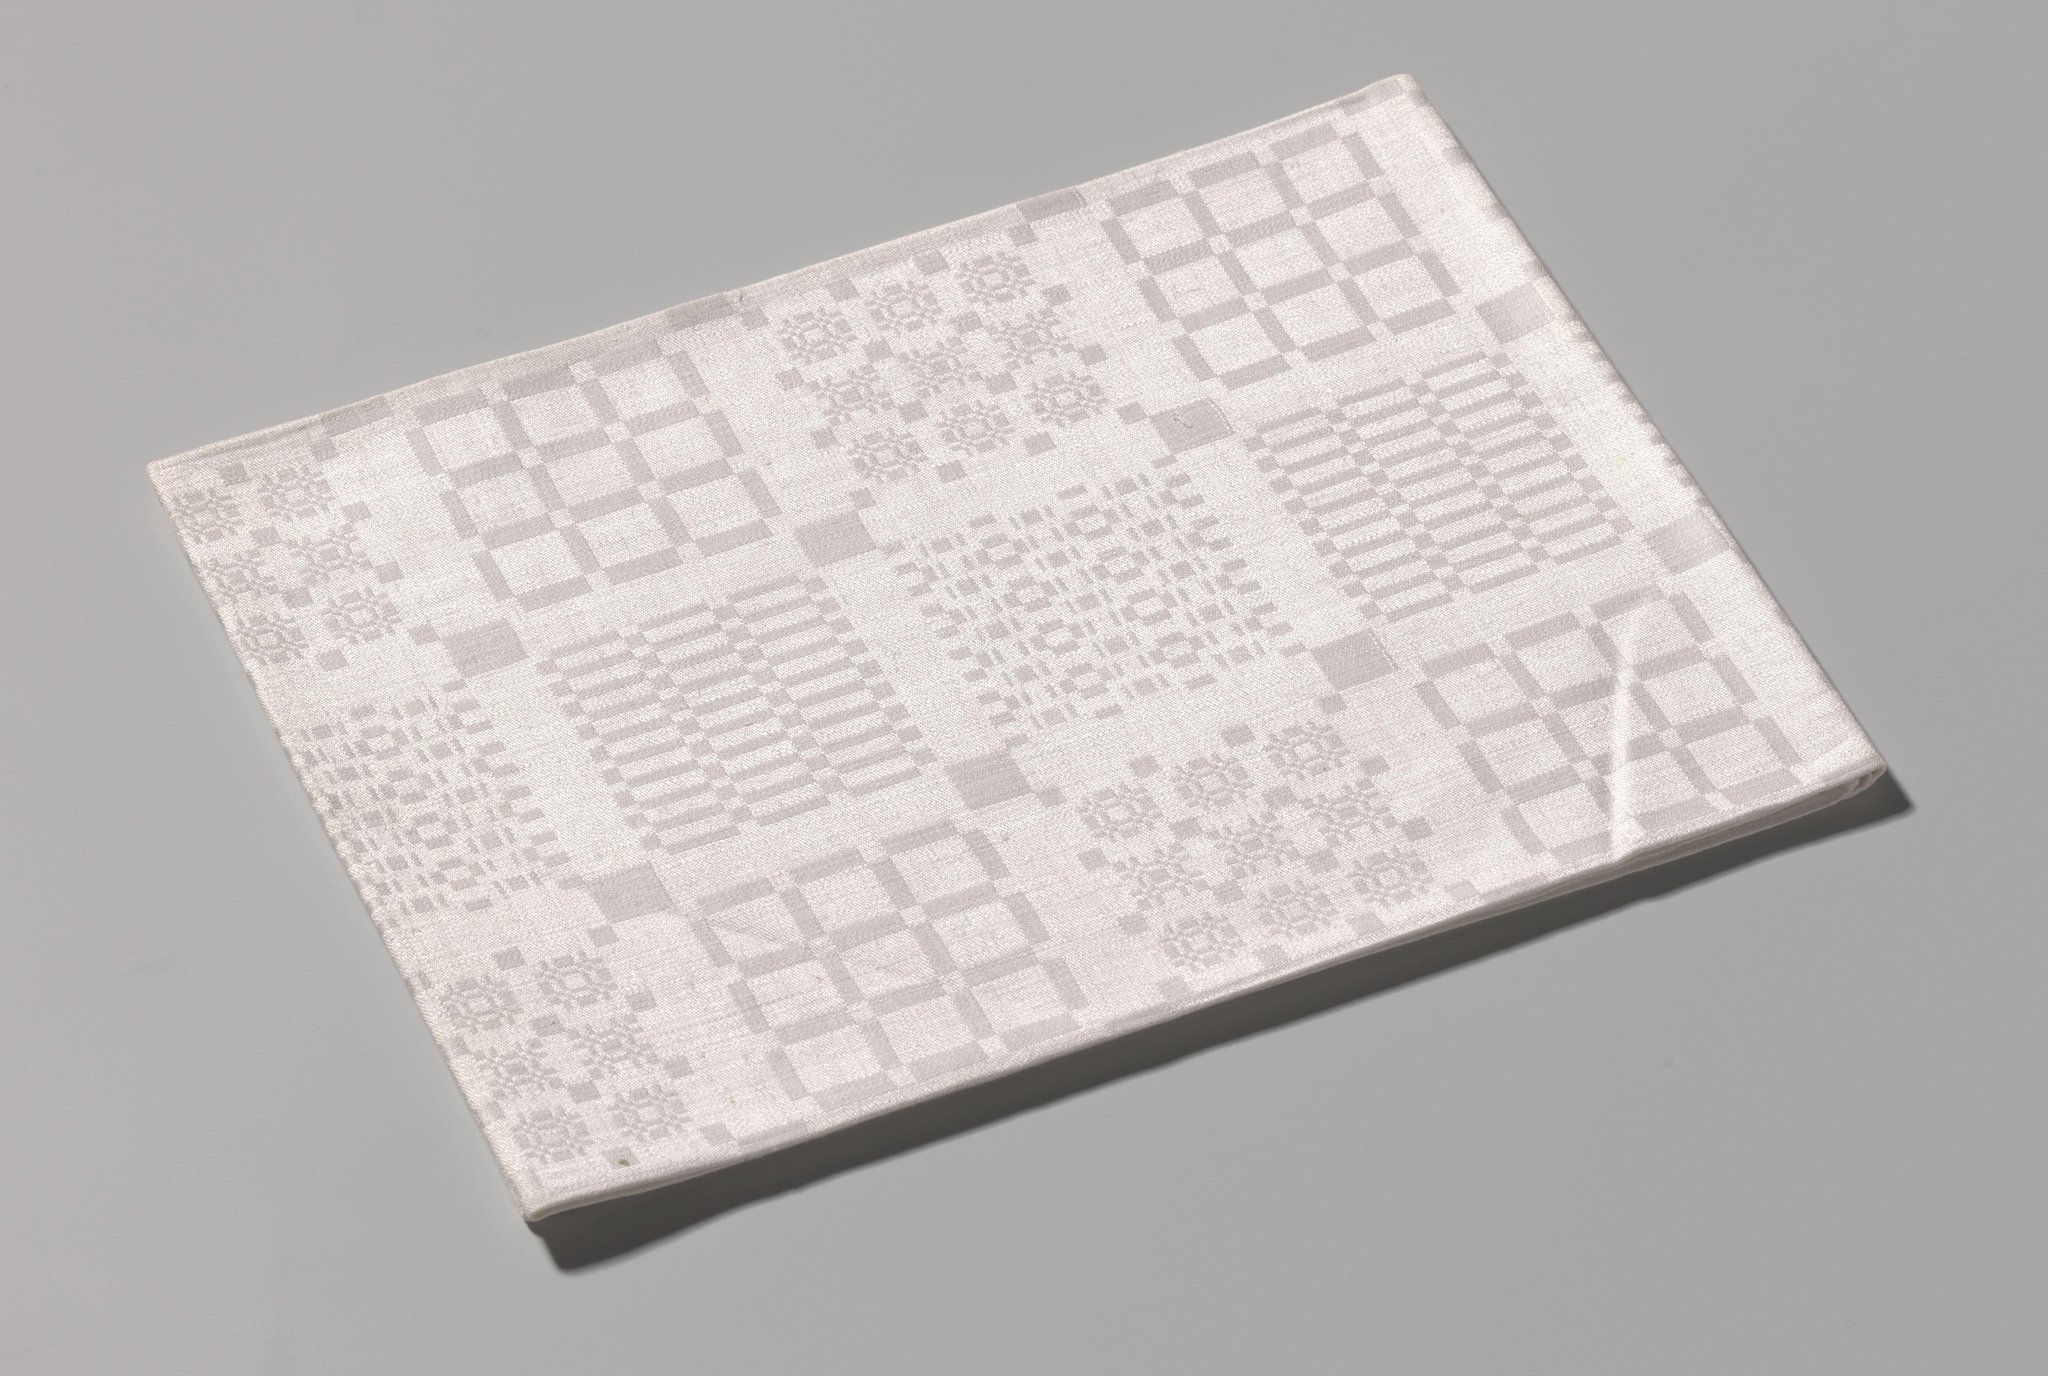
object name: napkin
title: Servet van linnen met pellenpatroon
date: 1737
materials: linen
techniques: peeled fabric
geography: northern netherlands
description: Wit linnen servet met pellenpatroon, genaamd "Oostindische caracters". Merk kroon WG 36 1737.